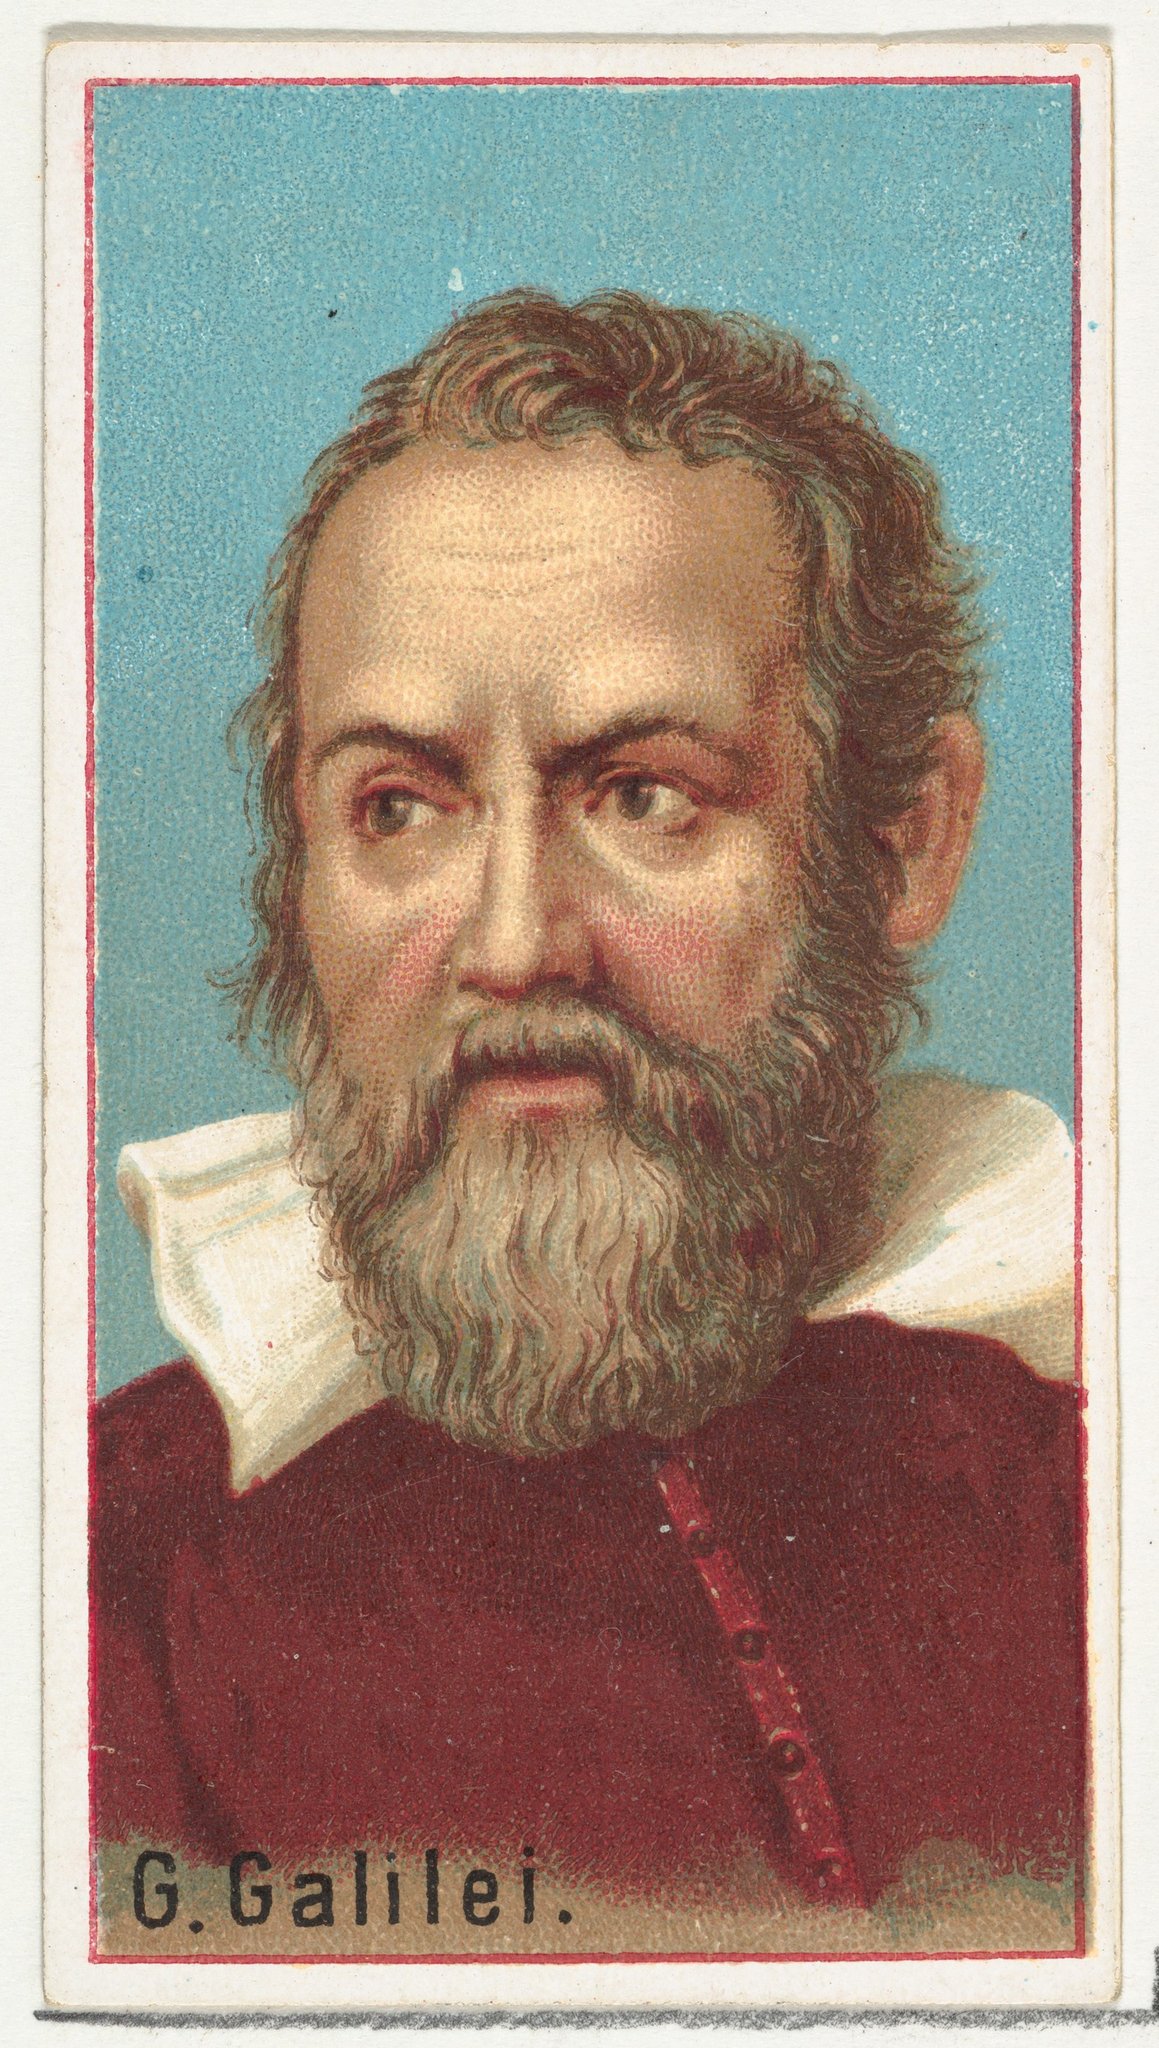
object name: print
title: Galileo Galilei, printer's sample for the World's Inventors souvenir album (A25) for Allen & Ginter Cigarettes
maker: allen & ginter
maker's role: publisher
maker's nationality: american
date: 1888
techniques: color lithograph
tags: men,portraits